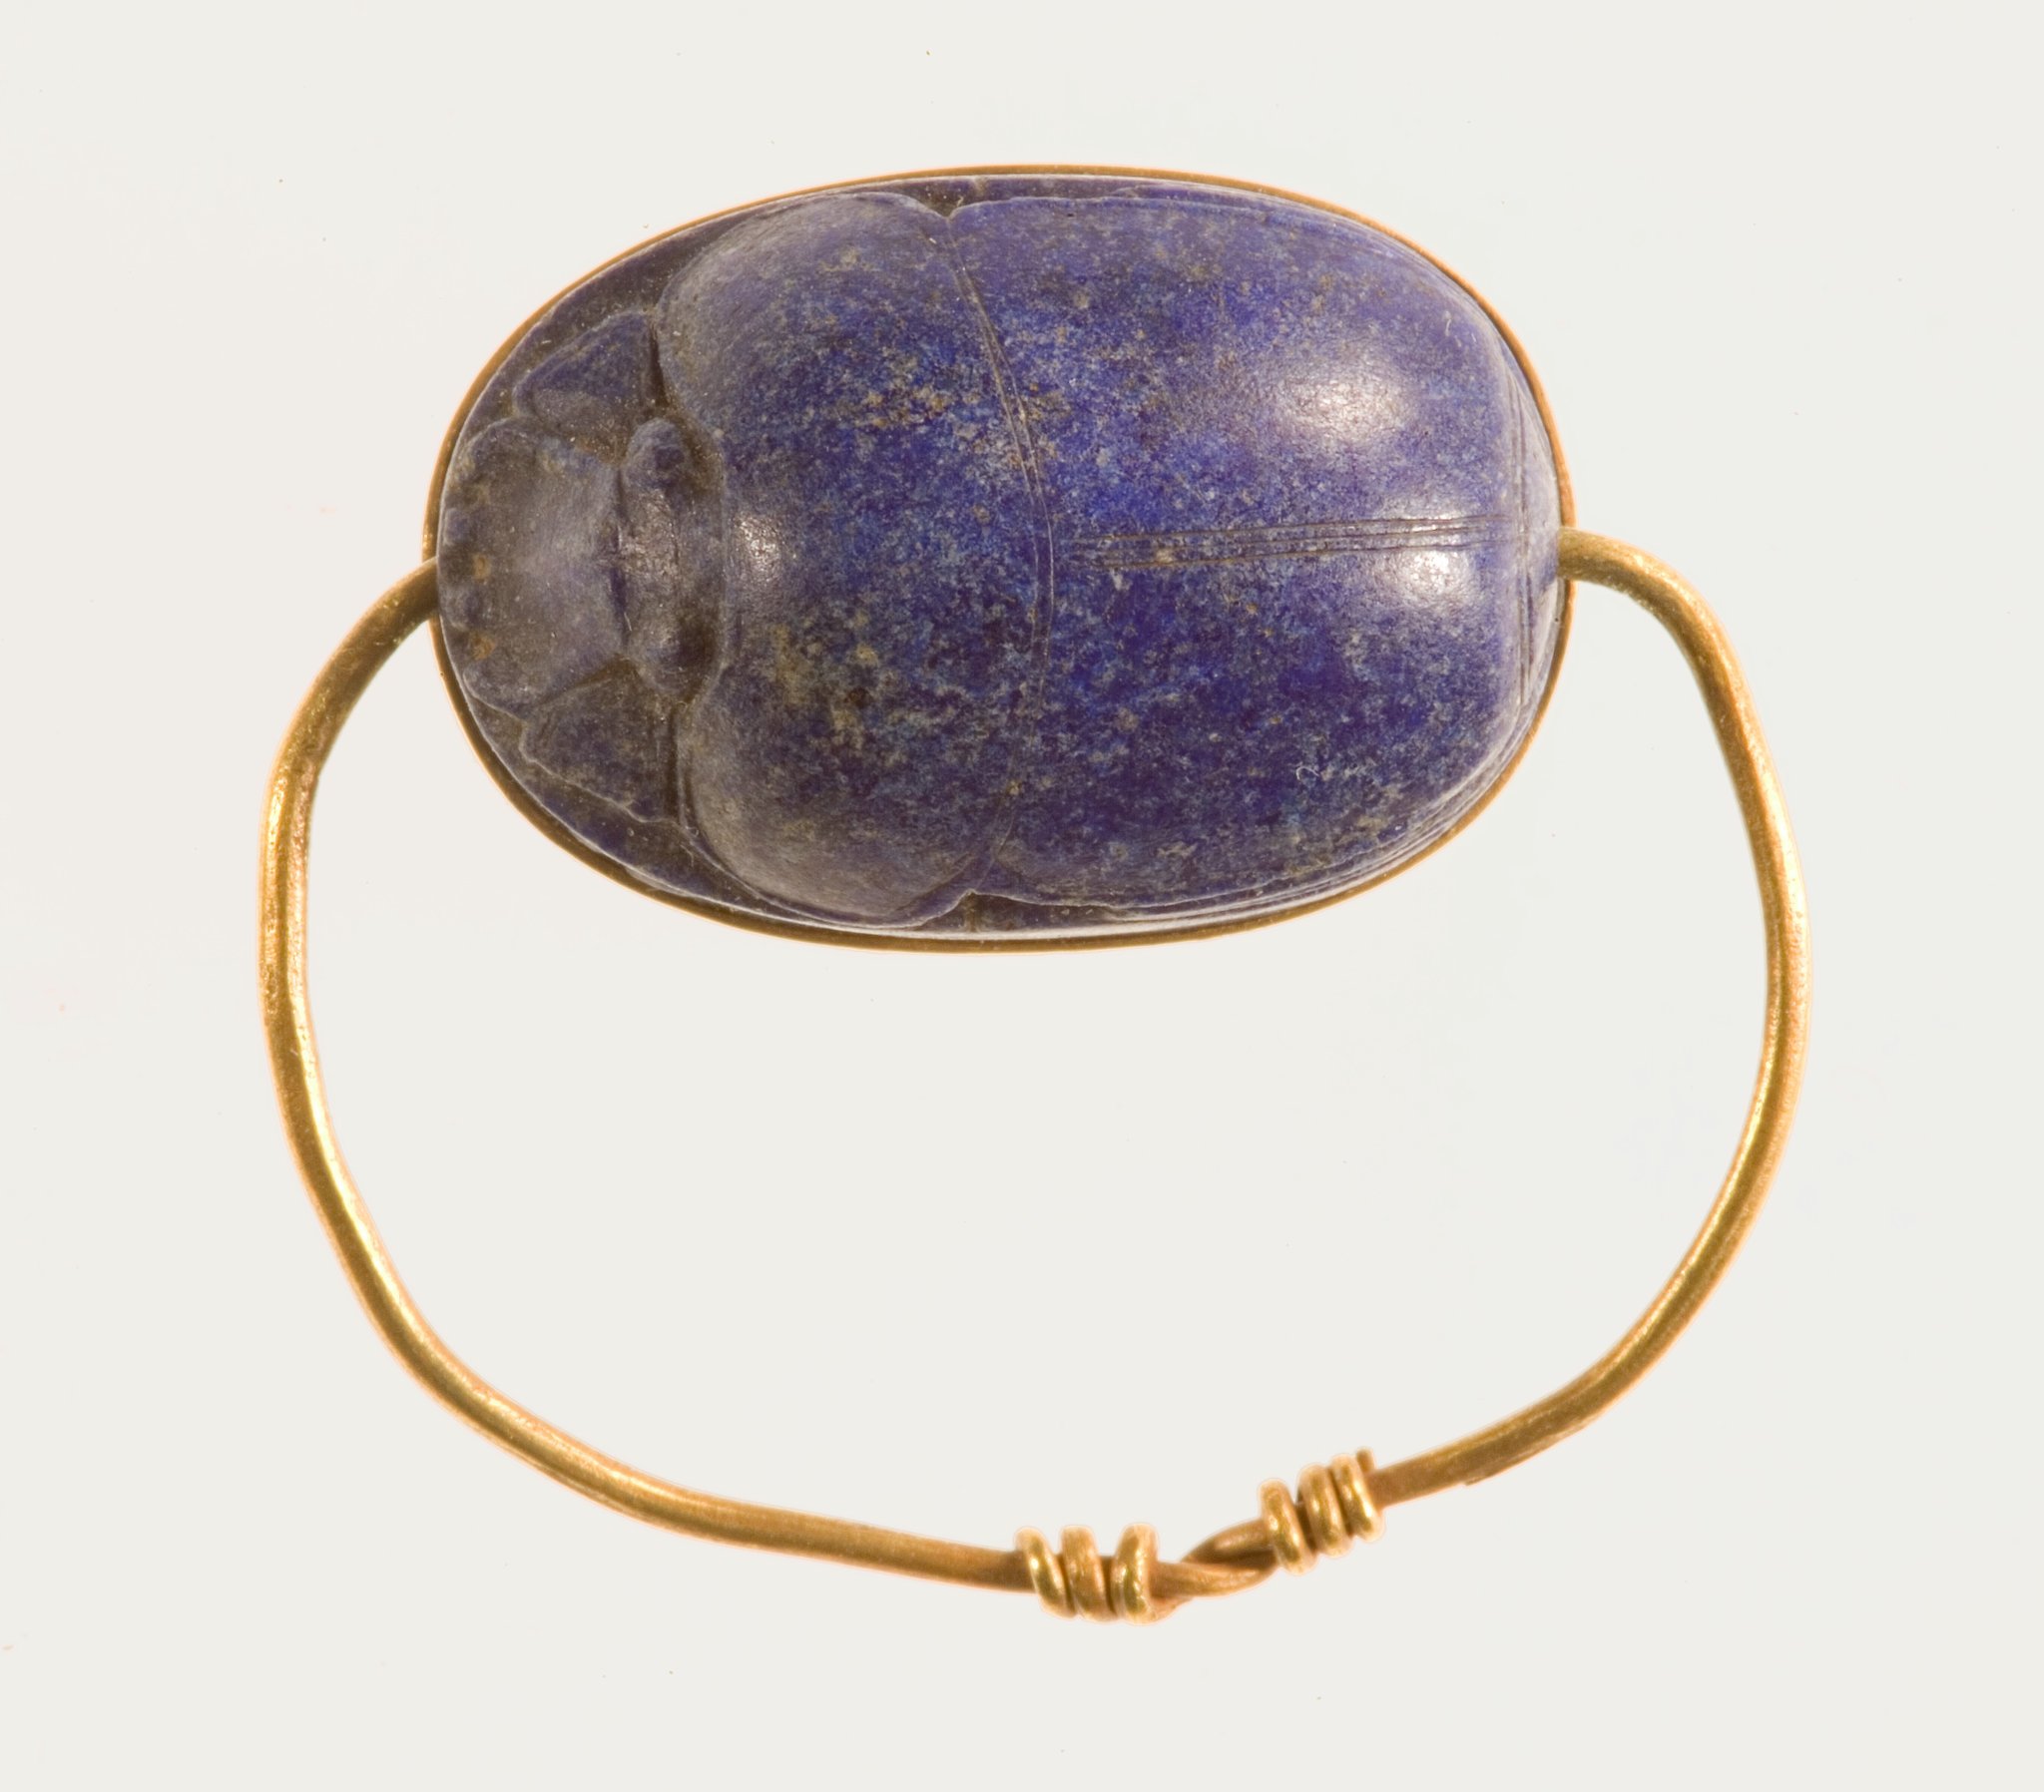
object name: ring with scarab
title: Scarab Finger Ring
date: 1850-1750 BCE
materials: gold, lapis lazuli, metal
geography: memphite region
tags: scarabs